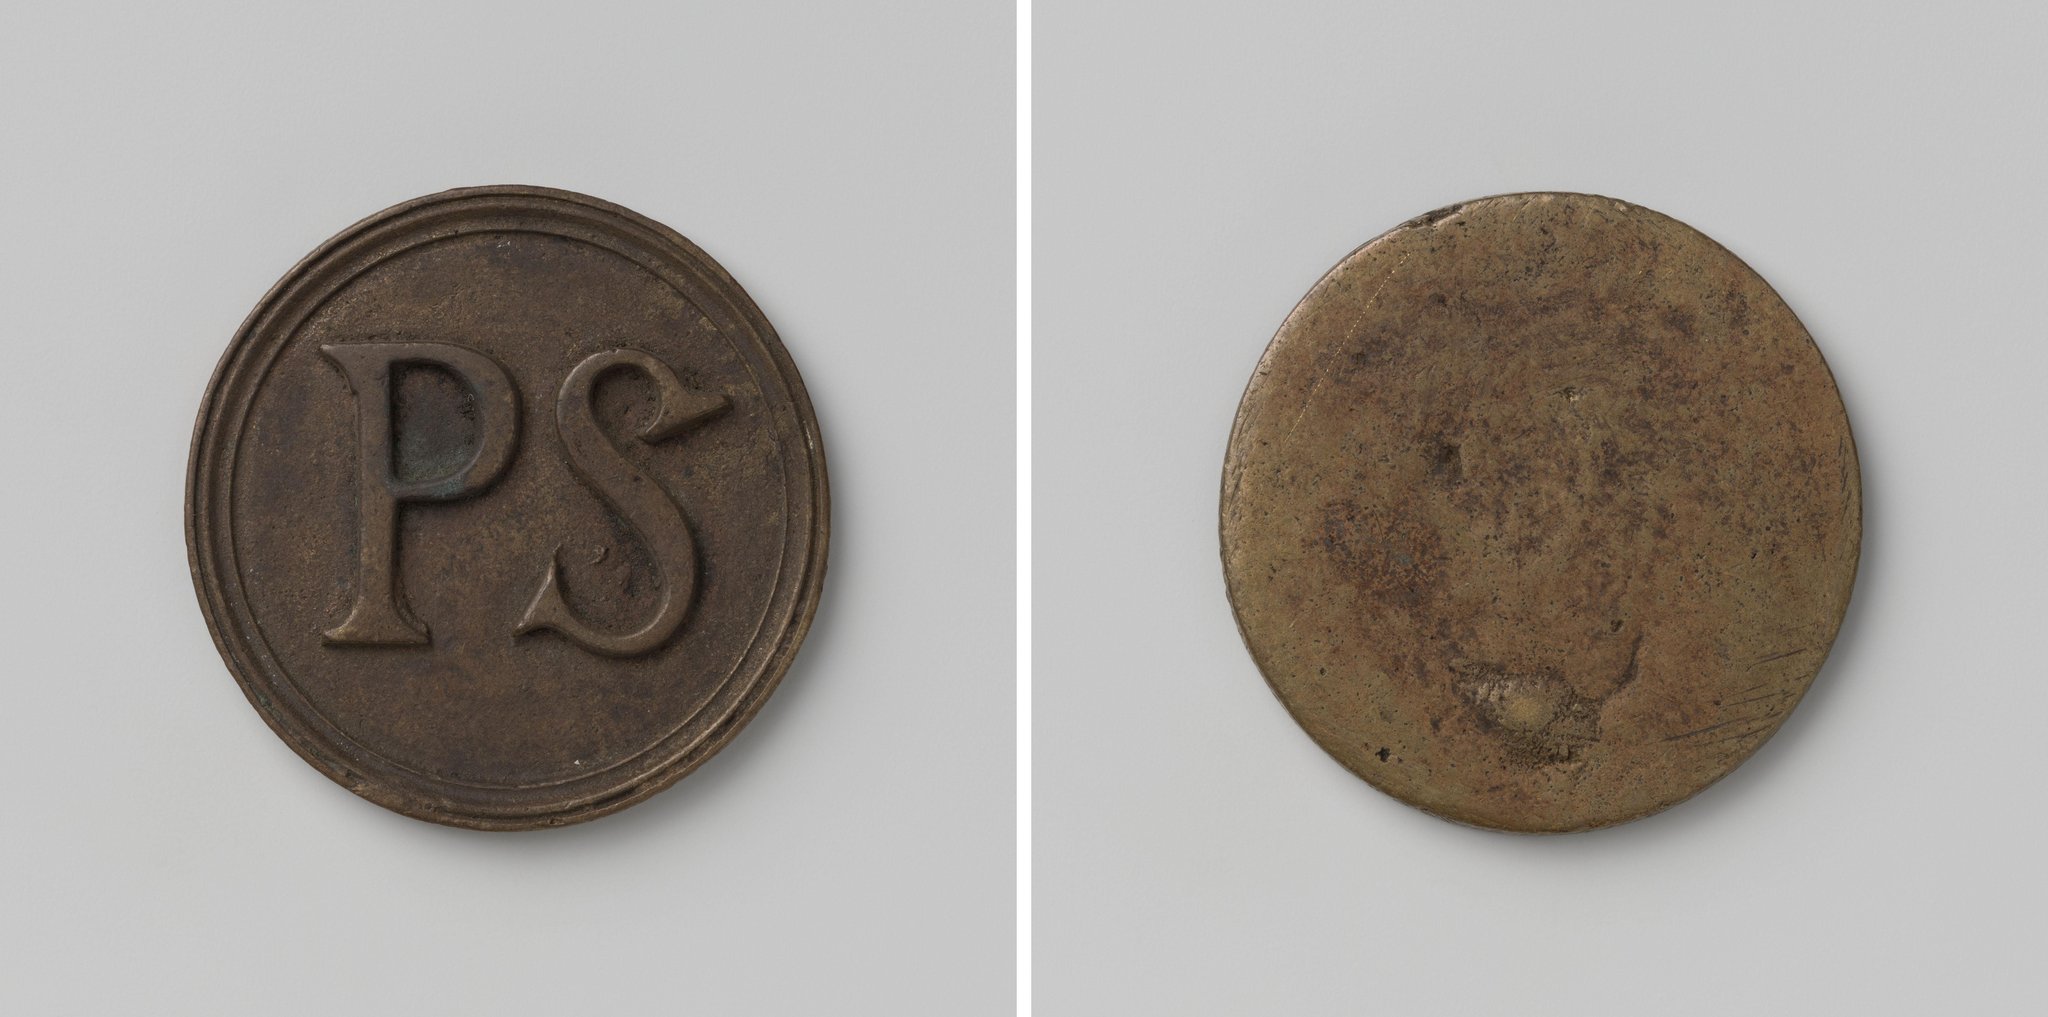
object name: lidmaatschapspenning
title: Onbekende plaats, lidmaatschapspenning met monogram P.S.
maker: Anonymous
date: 1650-1750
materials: brass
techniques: engraving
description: Eenzijdige messing penning. Voorzijde: monogram van letters P en S. Keerzijde: blanco